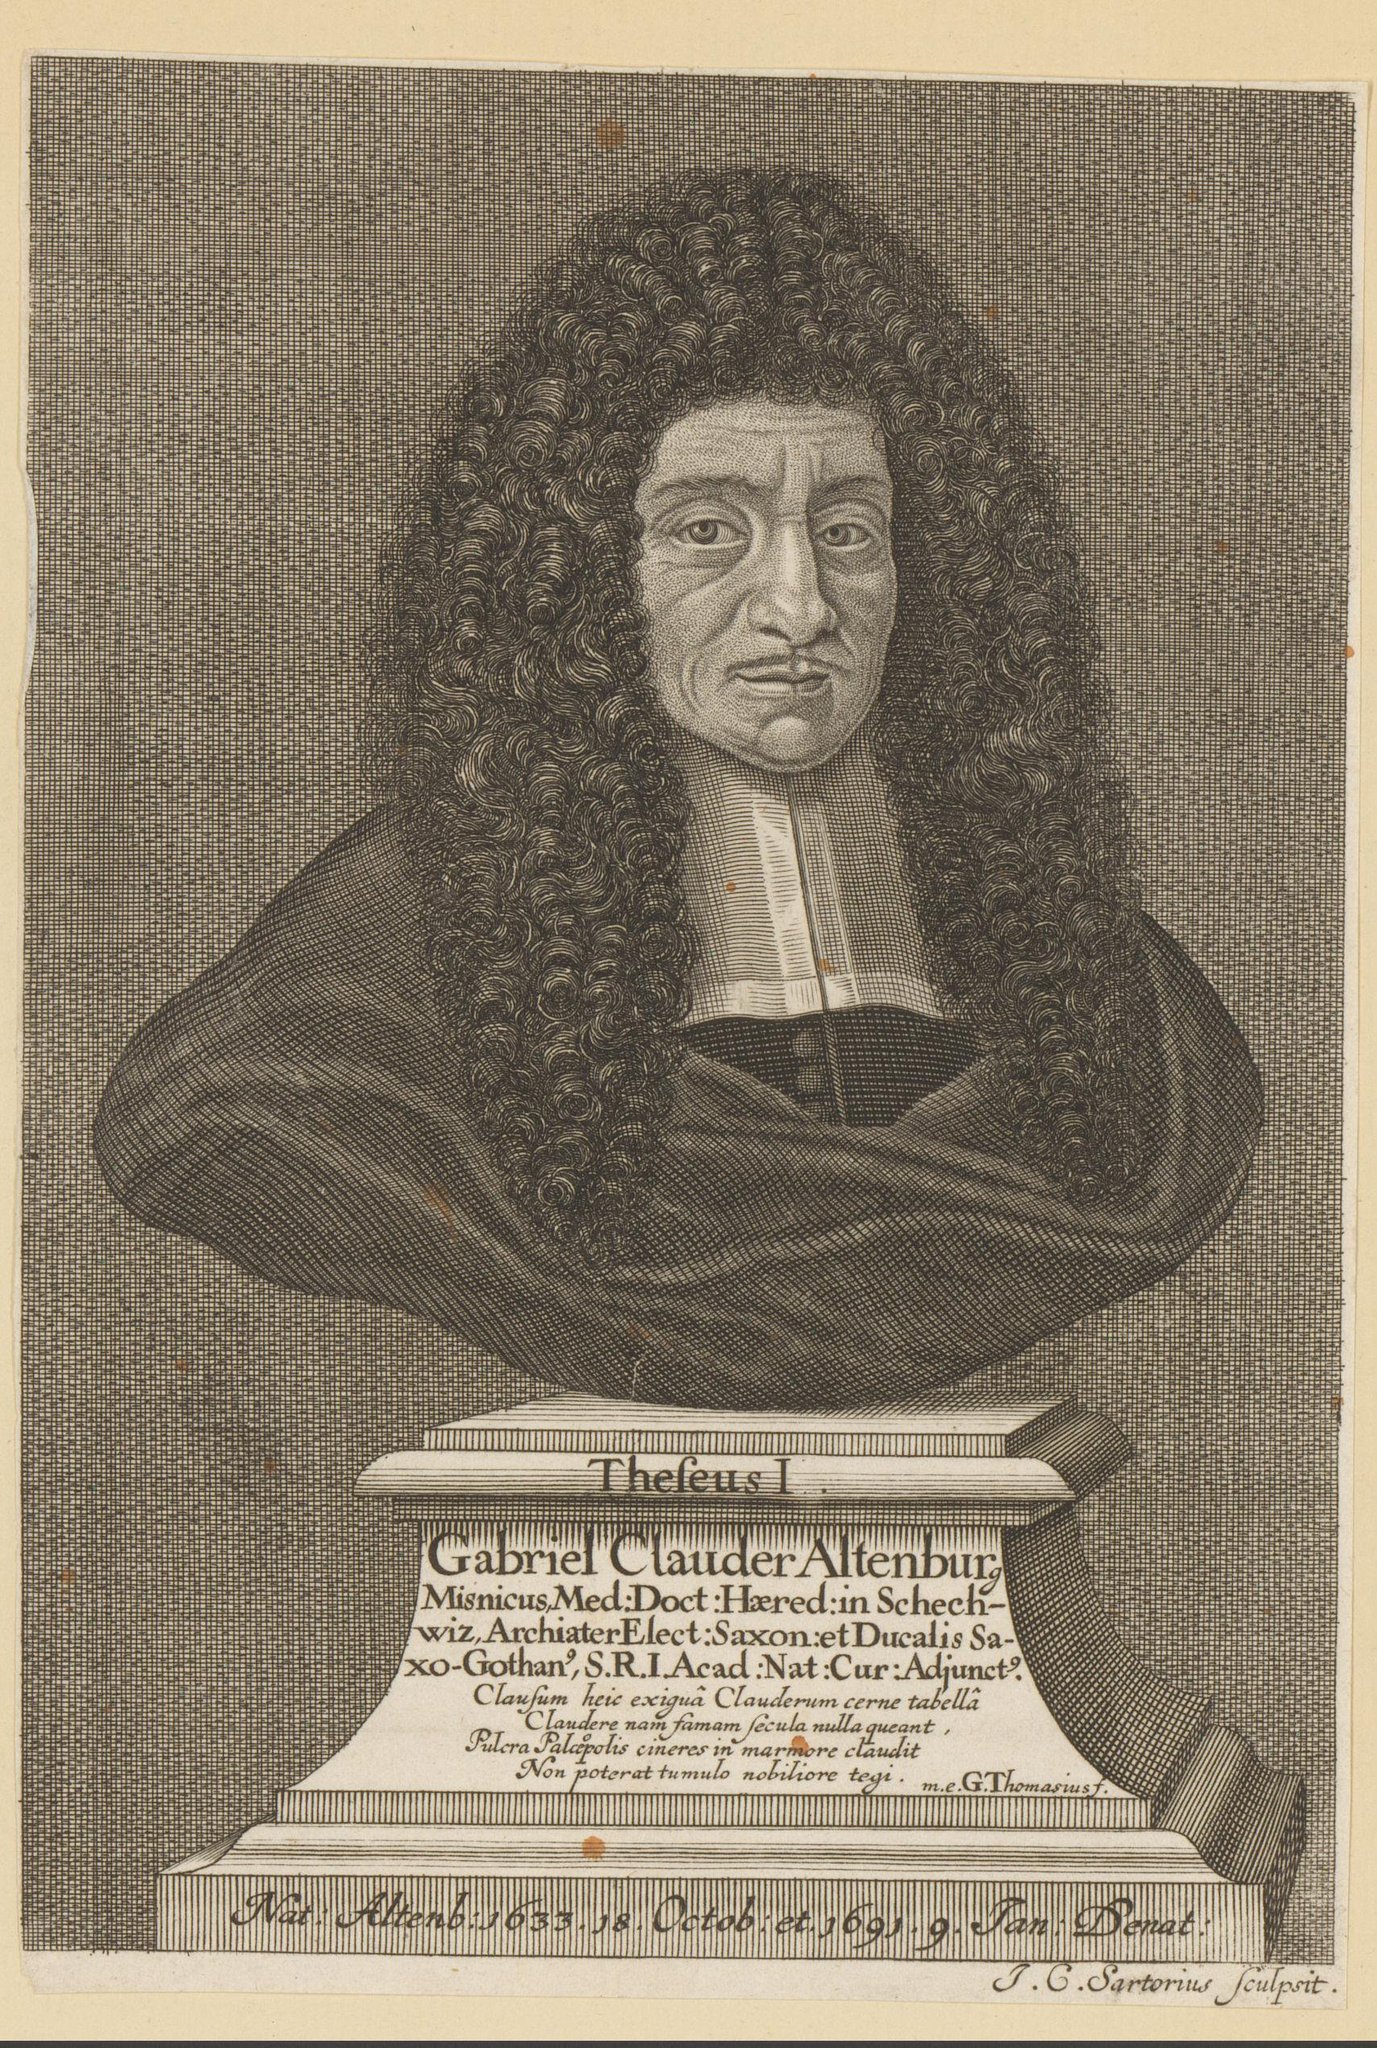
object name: print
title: Portret van Gabriel Clauder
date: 1691-1739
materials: paper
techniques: engraving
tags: historical persons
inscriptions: collector's mark: Lugt 2228